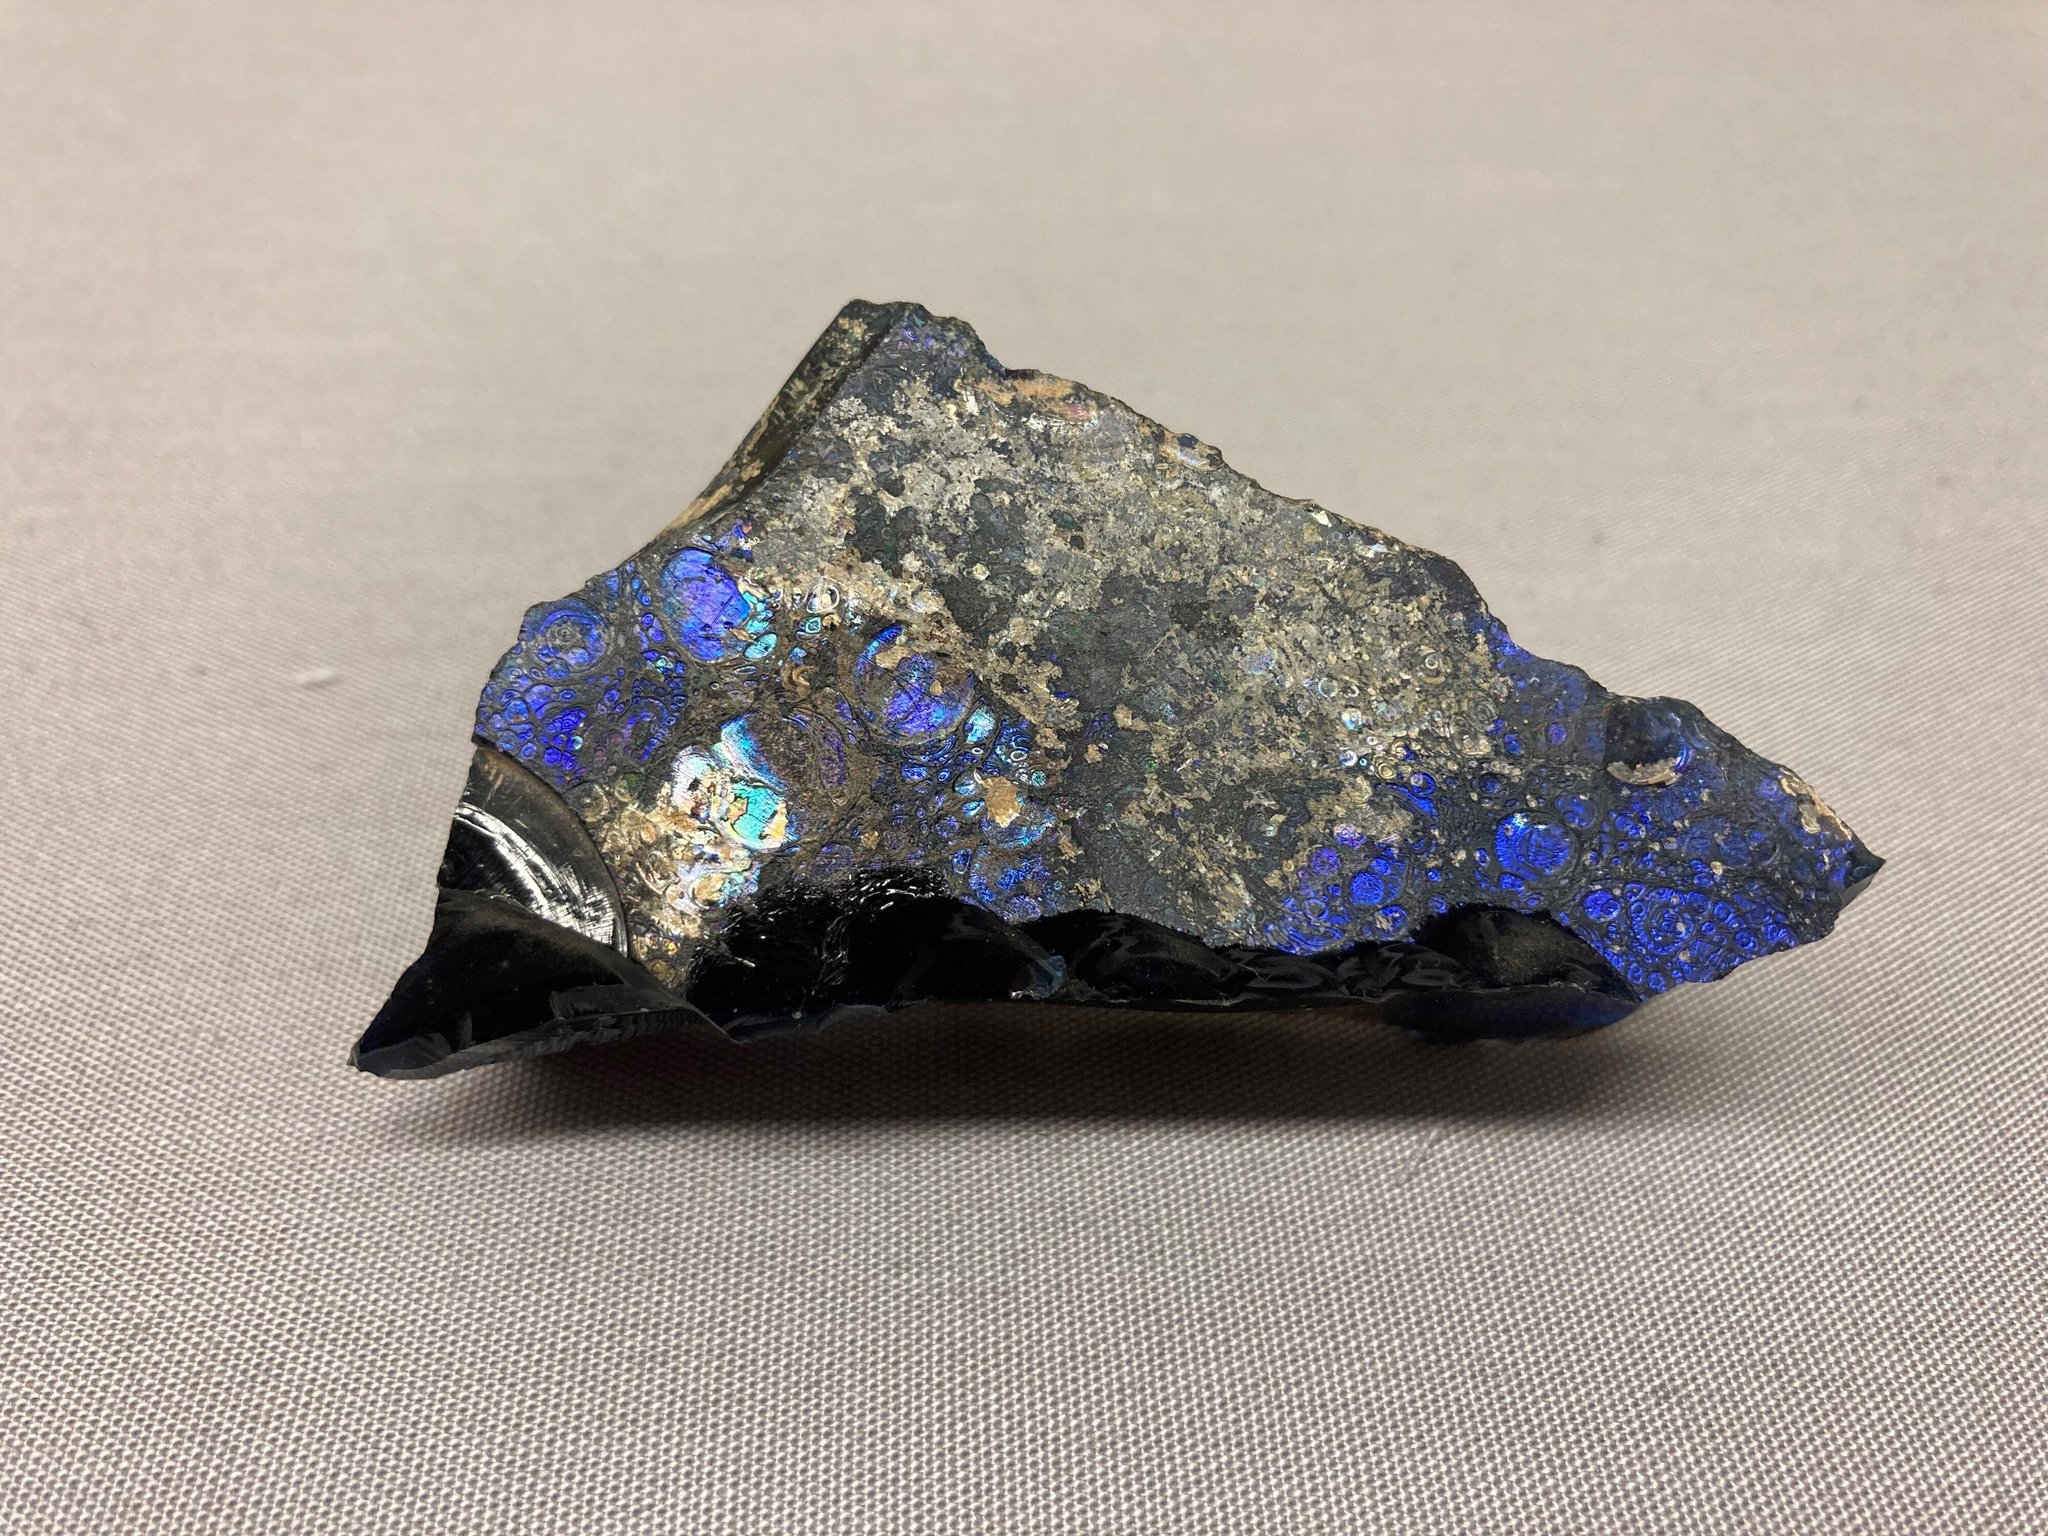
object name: fragment of ingot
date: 1101-1300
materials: glass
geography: iran